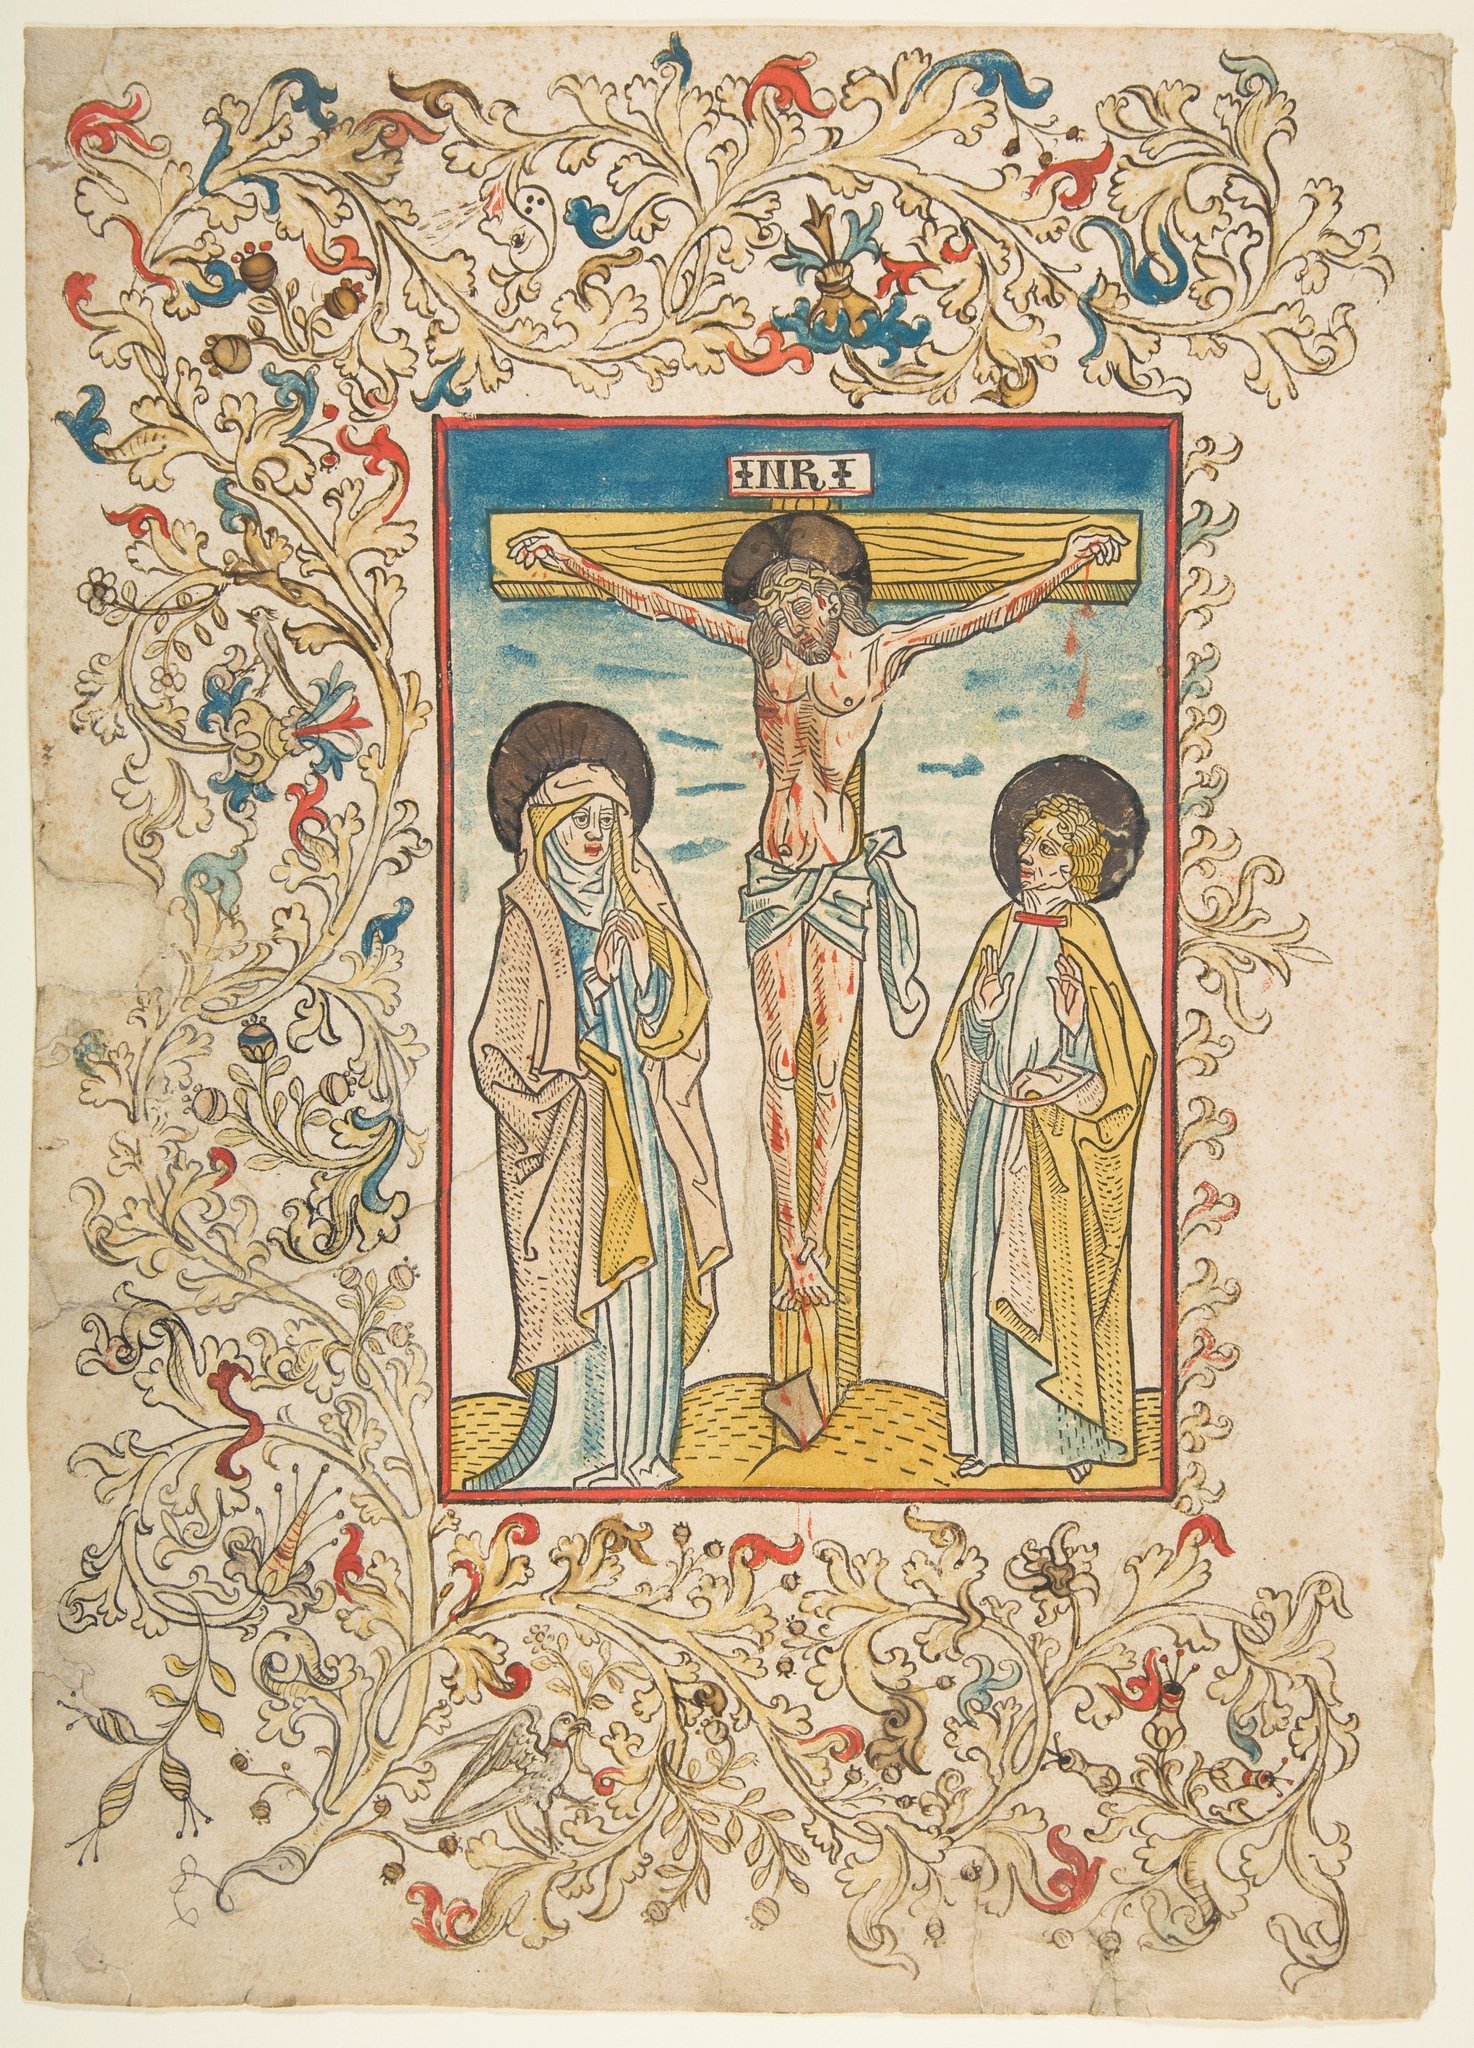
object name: print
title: Christ on the Cross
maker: anonymous, german, basel, 15th century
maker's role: artist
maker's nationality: german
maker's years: 1400-1500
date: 1401-1500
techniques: hand coloring, woodcut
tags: christ,virgin mary,cross,crucifixion